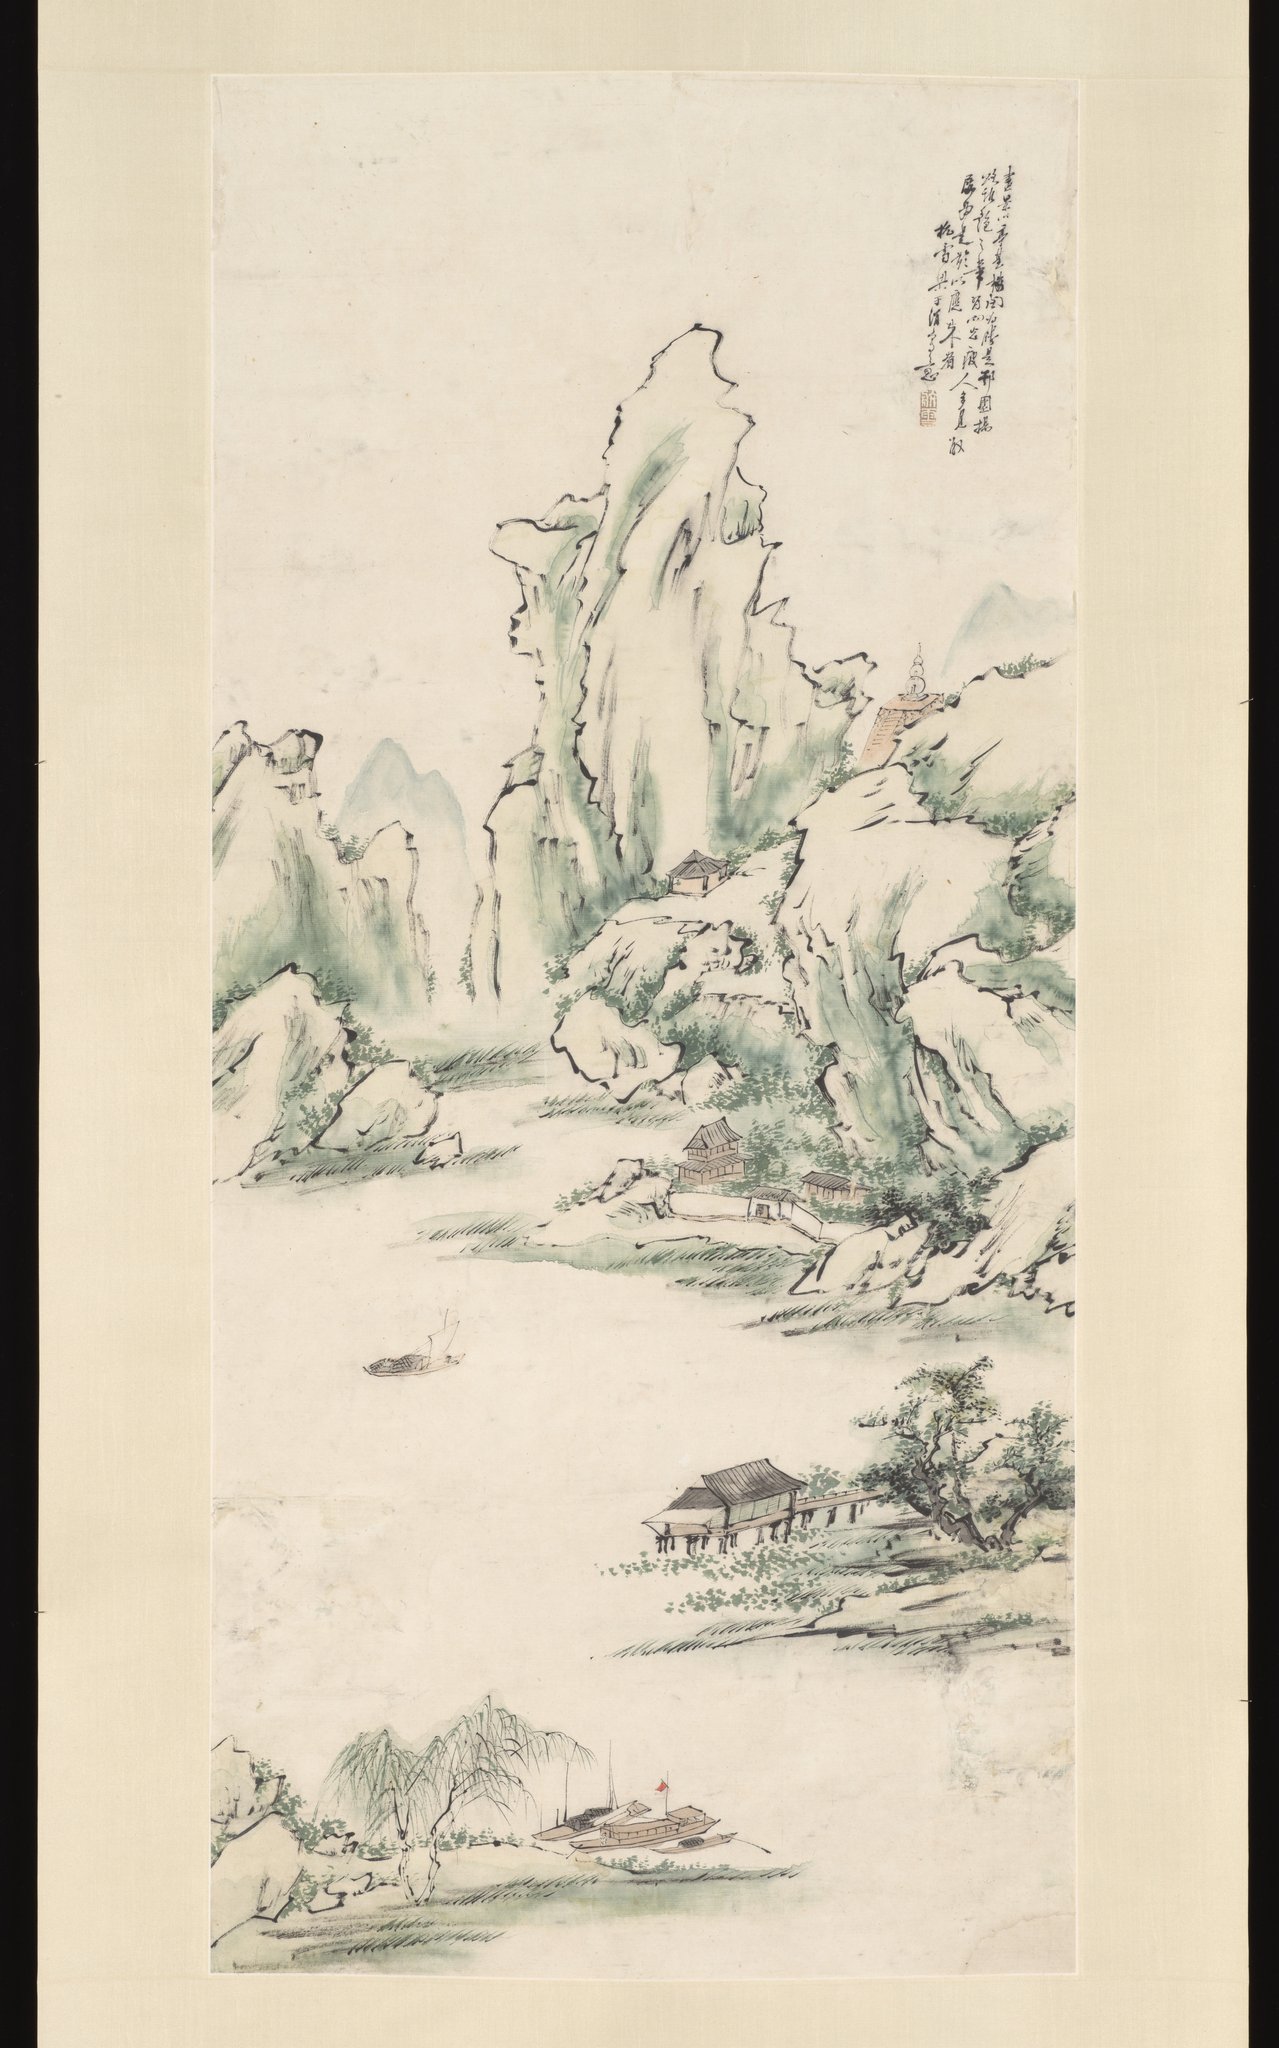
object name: hanging scroll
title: Snowscape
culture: chinese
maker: liang yuwei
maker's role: artist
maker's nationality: chinese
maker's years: 1844-1917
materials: ink, paper